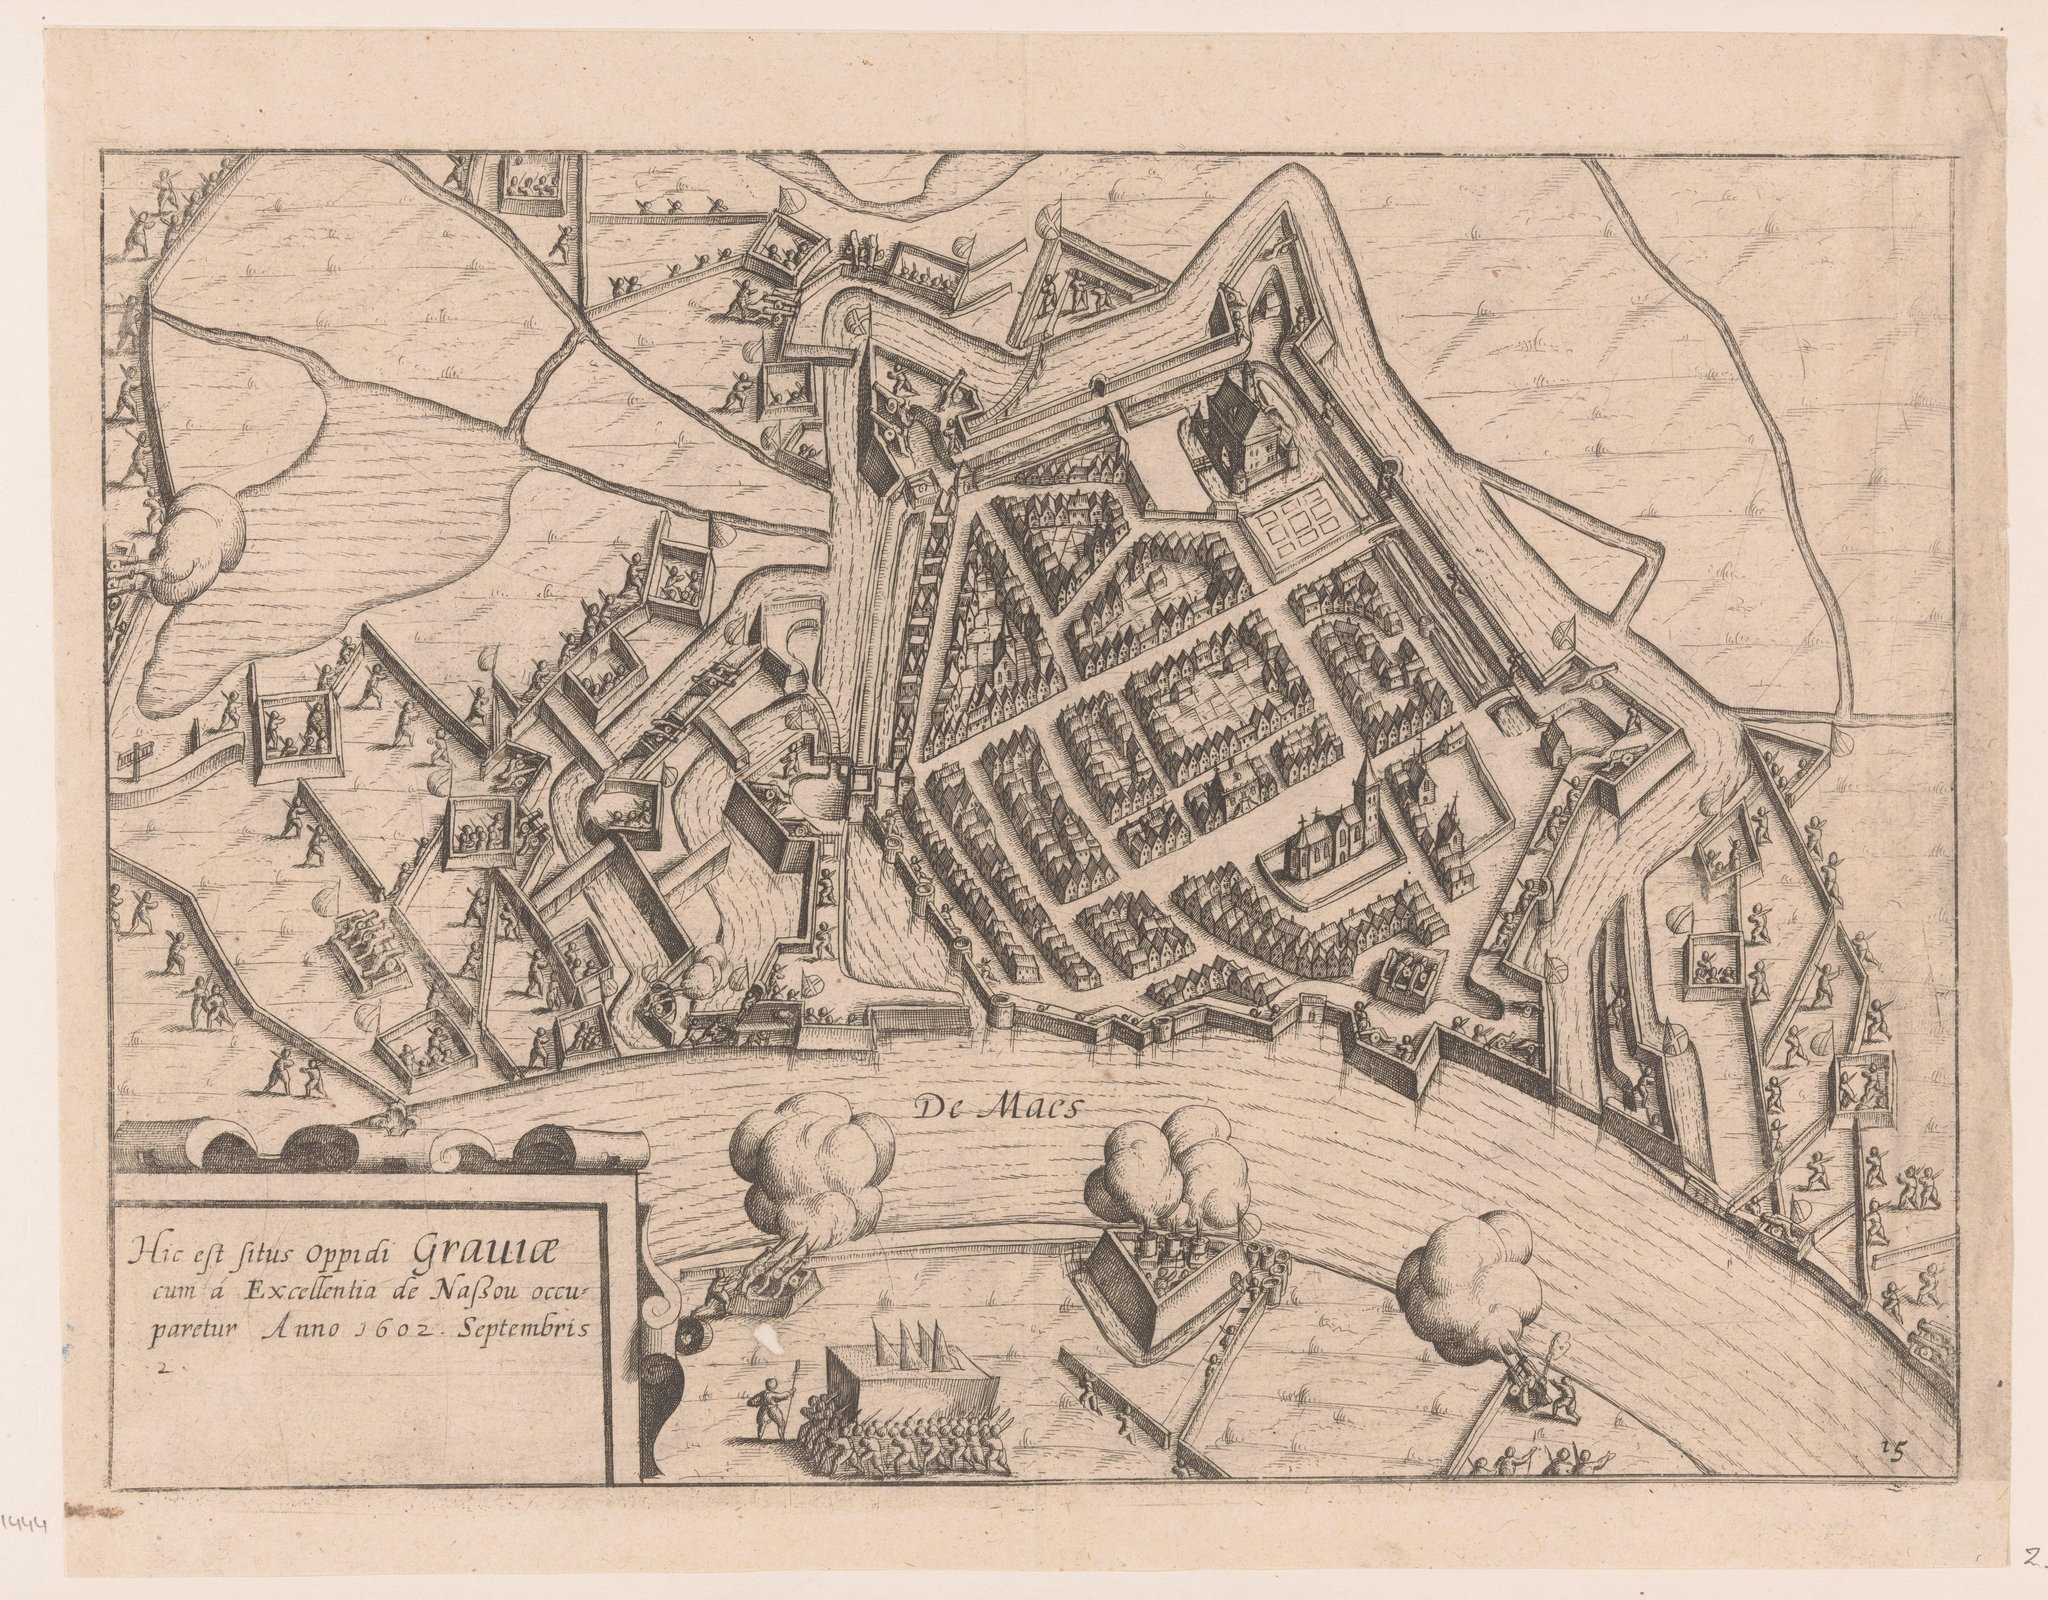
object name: area plan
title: His est situs oppidi Graviae cum á excellentia de Nassou occuparetur anno 1602 septembris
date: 1612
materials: paper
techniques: engraving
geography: amsterdam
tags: the hague, maurice (prince of orange), maps of cities, siege, grave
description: Deze plattegrond voor het eerst gebruikt in: Guicciardini, Lodovico. Beschryvinghe van alle de Neder-landen (...). Amsterdam: Willem Jansz. Blaeu, 1612. Ook gebruikt in de Latijnse editie van 1613, en in een aantal edities uitgegeven door Janssonius (1624-1648). Zie Deys, 2001 voor details.